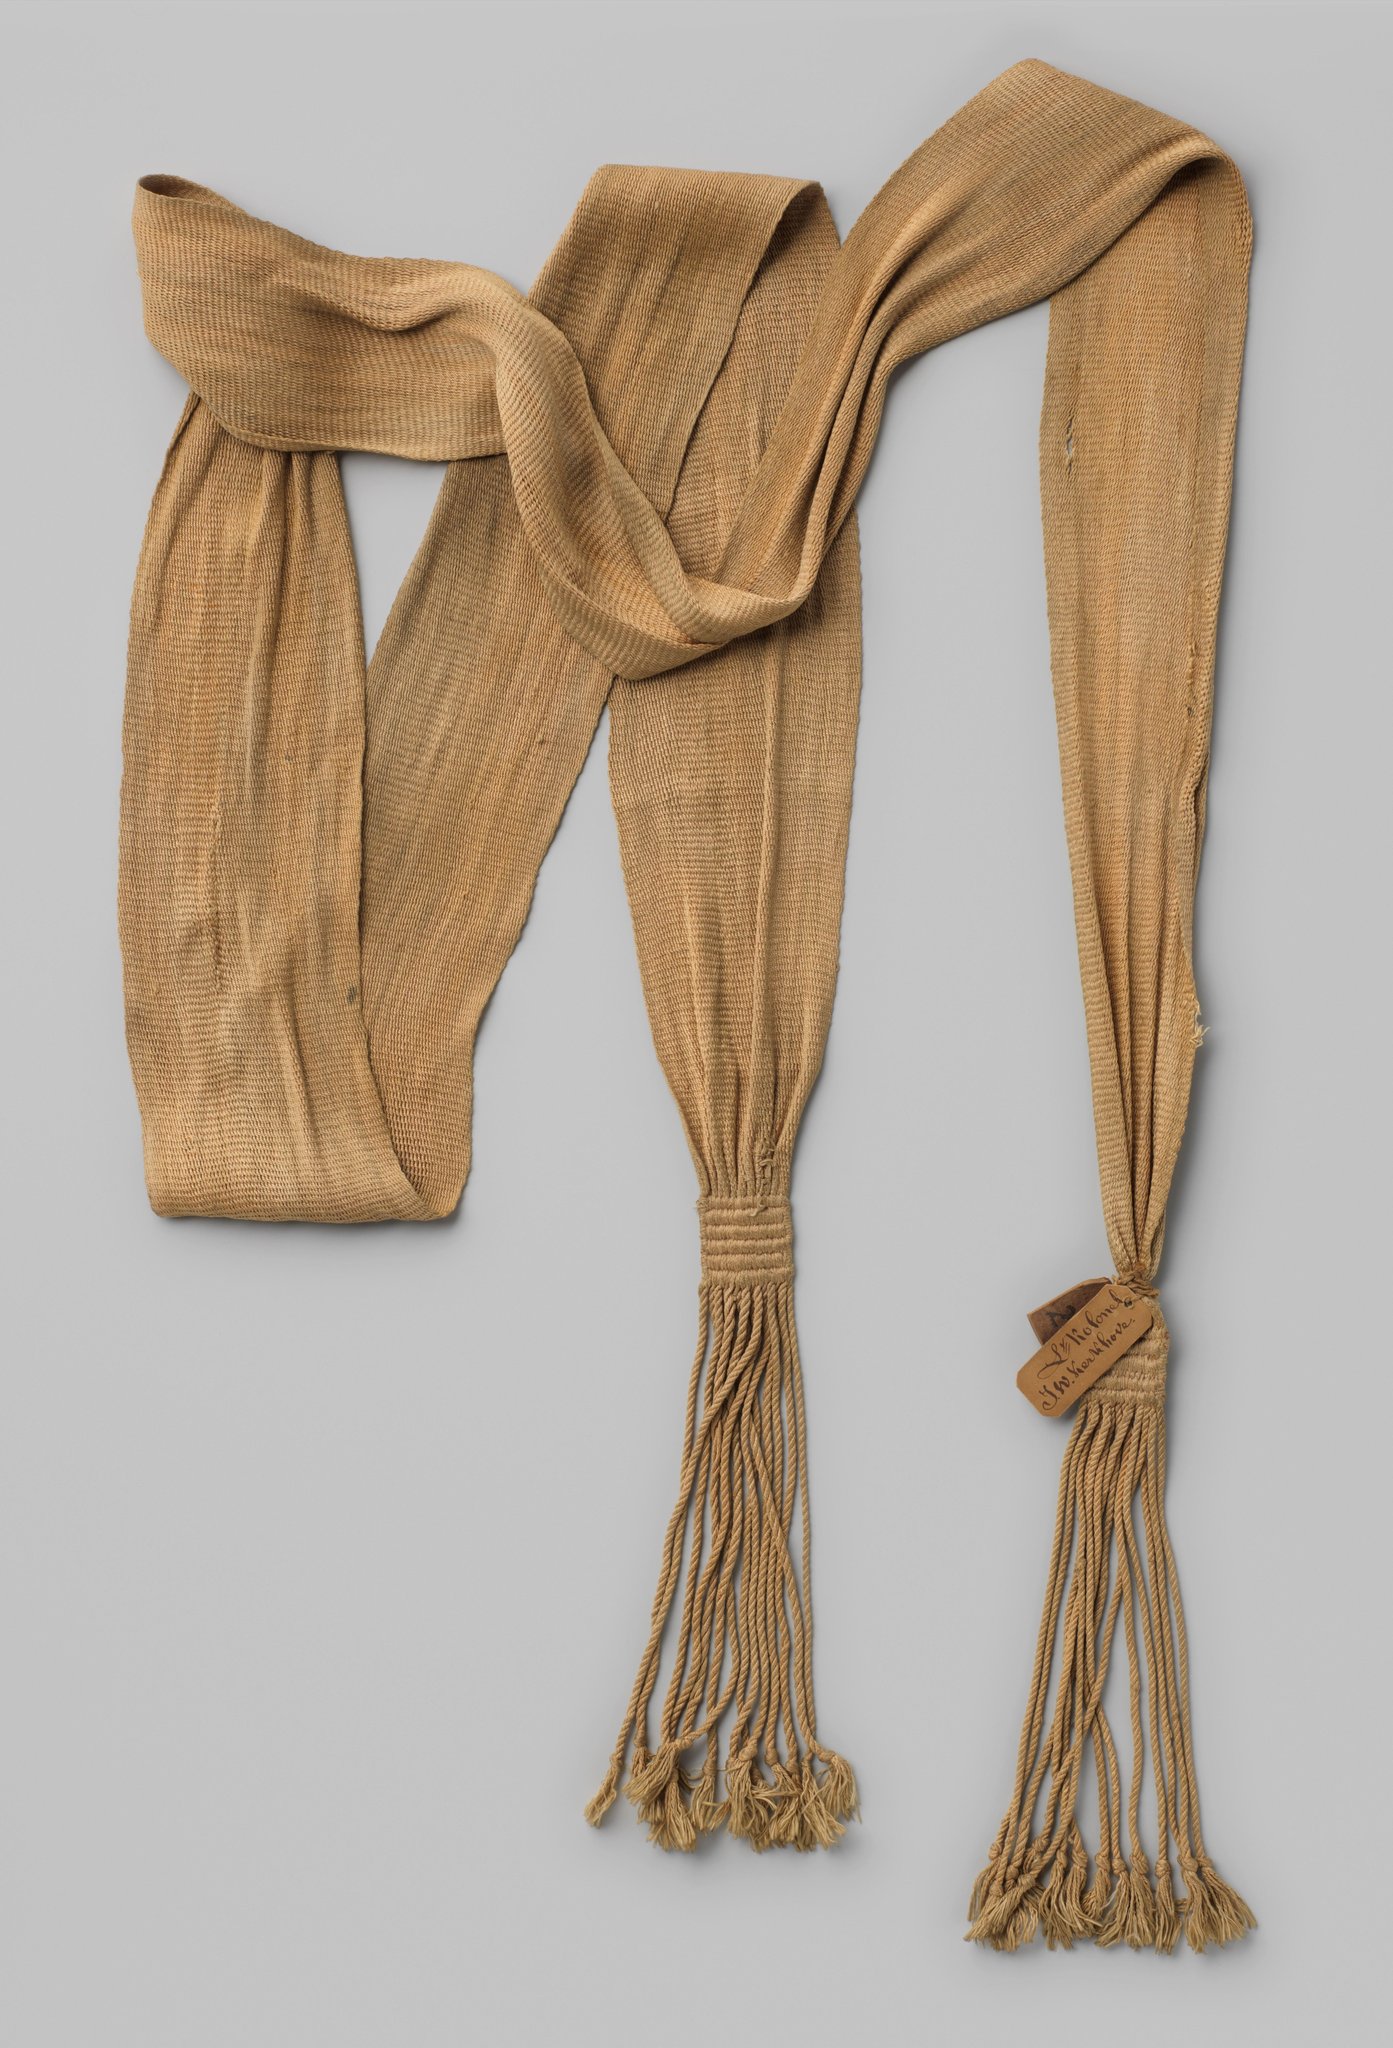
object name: sash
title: Sjerp van oranje zijde gedragen door J.W. Kerkhoven, in 1830/32 Luitenant Kolonel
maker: Anonymous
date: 1815-1830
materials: silk, wool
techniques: braiding, knotting, stitching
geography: netherlands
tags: netherlands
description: Sjerp van oranje koordzijde, verfletst, met vlekken en gaten, in techniek van "Egyptisch vlechtwerk". Etiket met tekst Lt. Kolonel J. W. Kerkhoven aangebracht. Beide uiteinden van de sjerpen zijn bij elkaar (geweven of gestikt?). Aan een zijde zijn vijf verticale banden, Aan de andere zijde zes verticale banden aangebracht, waaraan lange franjes hangen, elk aan de onderzijden voorzien van een knoop.